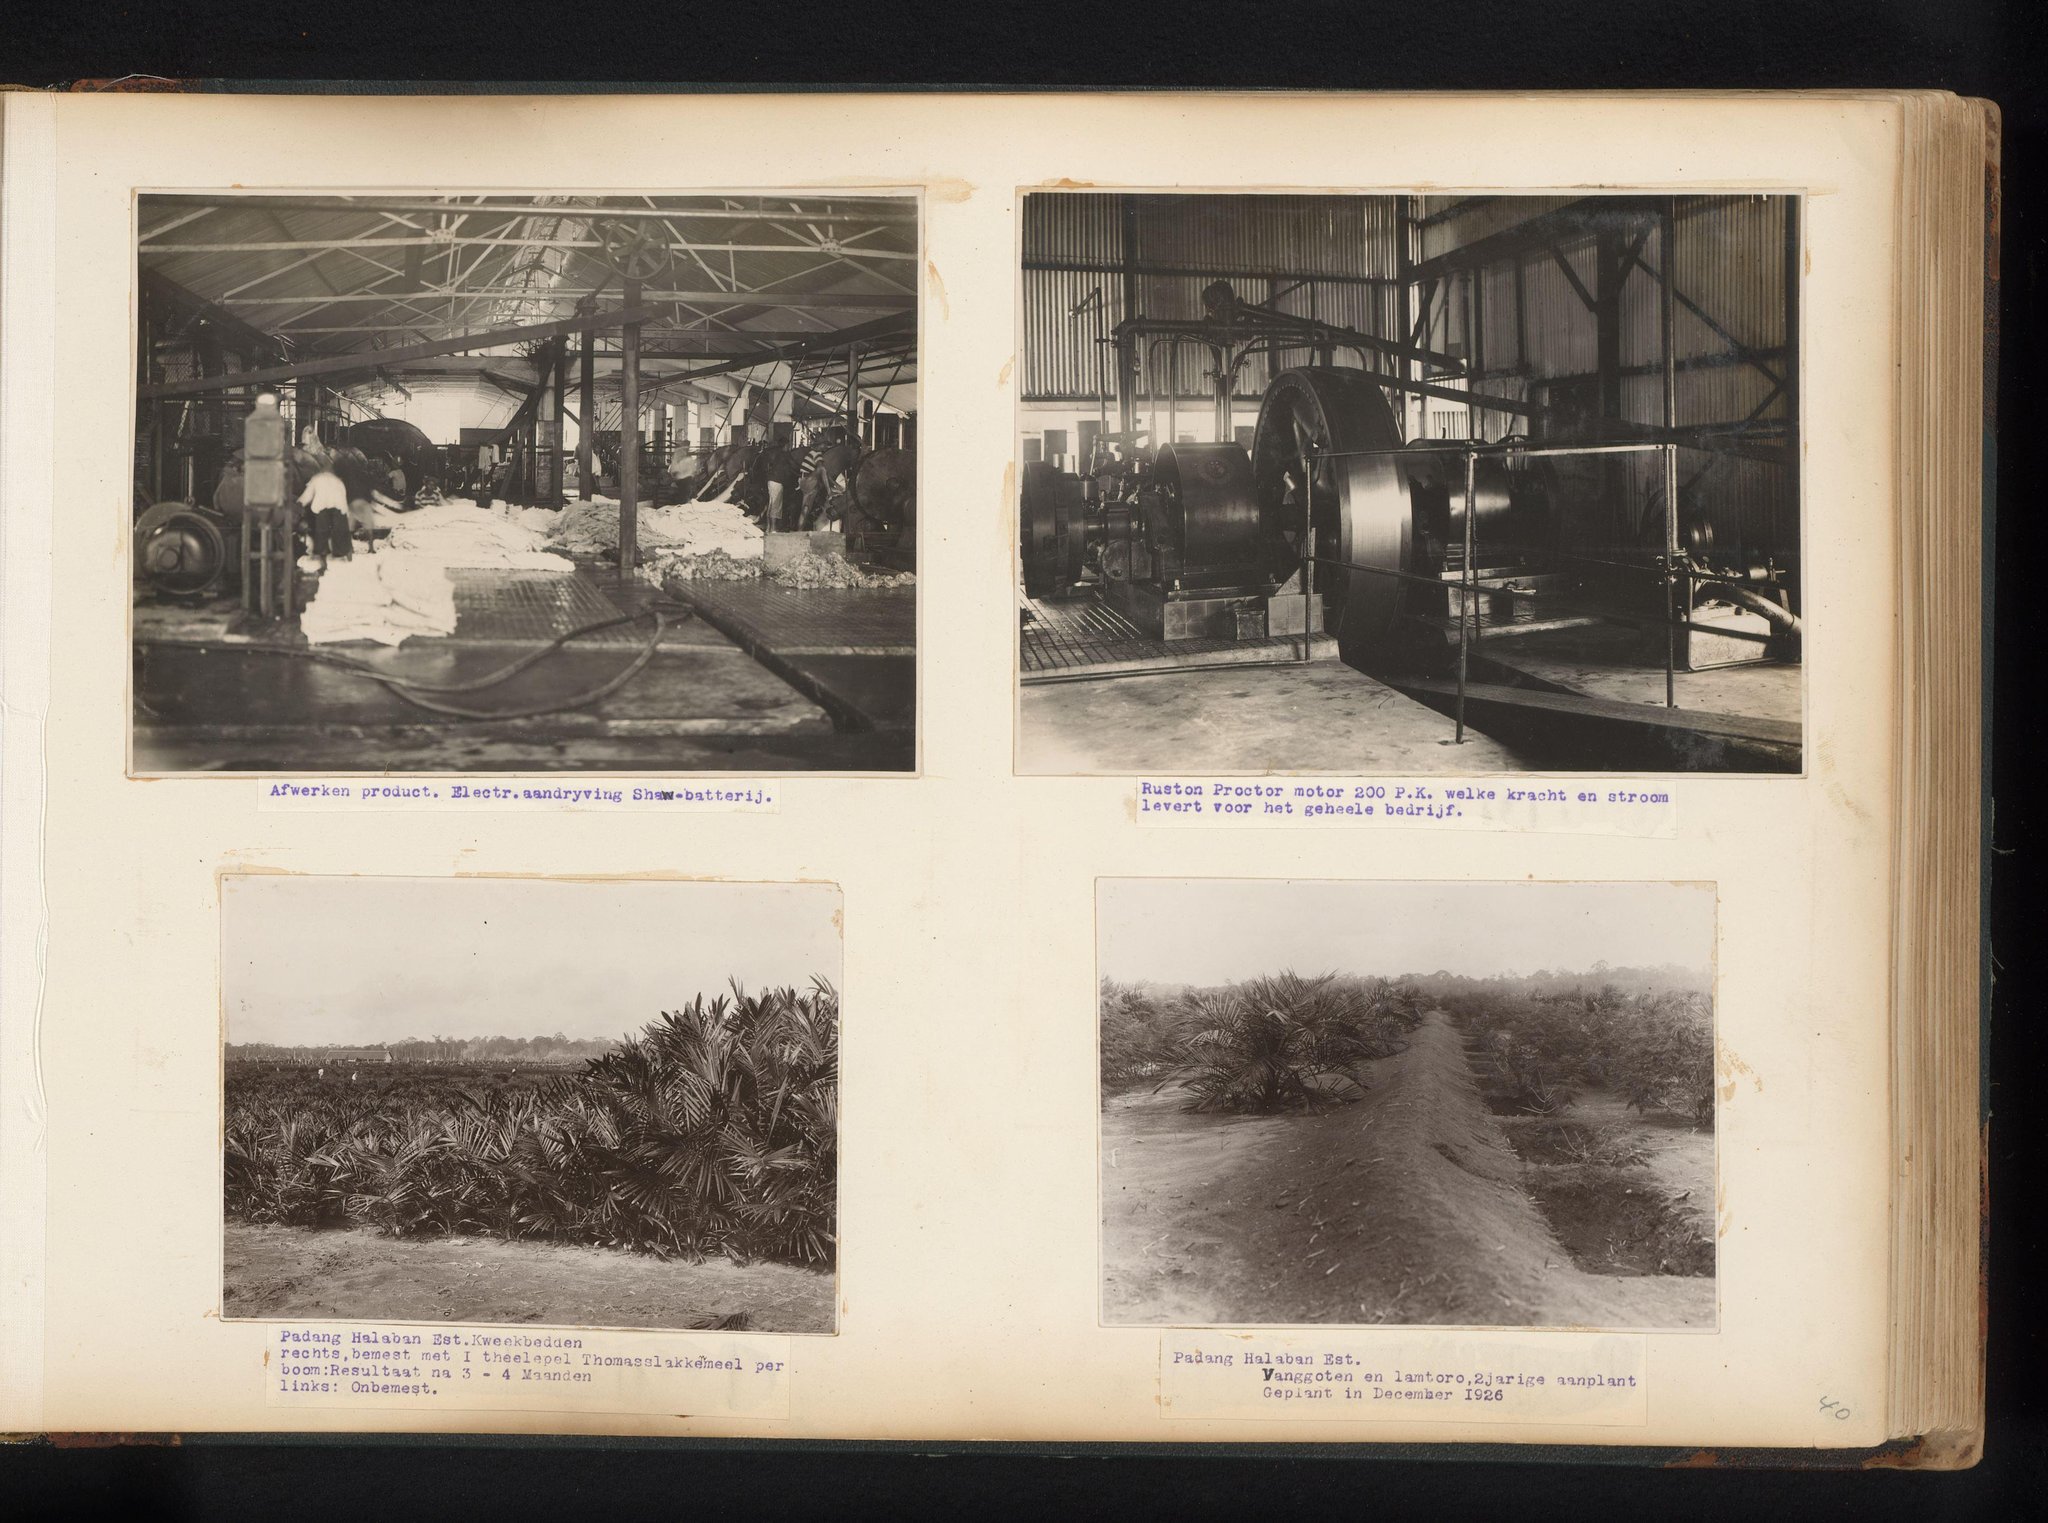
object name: album leaf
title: Rubberproductie en oliepalmen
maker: Anonymous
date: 1927-1928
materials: cardboard, photographic support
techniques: gelatin silver print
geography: sumatra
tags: plantation, (non-fruit) products of plants or trees: rubber, interior of industrial structures (regardless of the materials processed or the products made, (non-fruit) products of plants or trees: palm oil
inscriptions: inscription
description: Blad met vier foto's van rubberproductie op Pernantian en oliepalmen op Padang Halaban Estate, ca. 1927-1928. Onder de foto's etiketten met onderschriften. Onderdeel van het fotoalbum over de plantages Brussel en Pernantian van de Sumatra Caoutchouc Maatschappij op de Oostkust van Sumatra in de jaren 1910-1935.